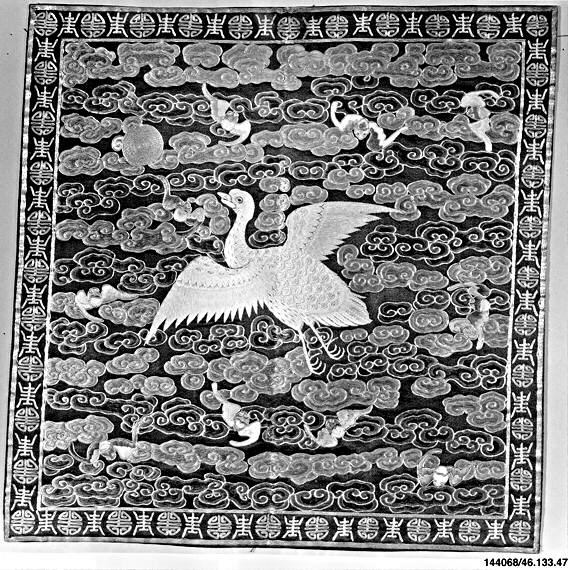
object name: rank badge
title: Rank Badge with Wild Goose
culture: chinese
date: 1867-1900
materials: metal thread, silk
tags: bats,geese